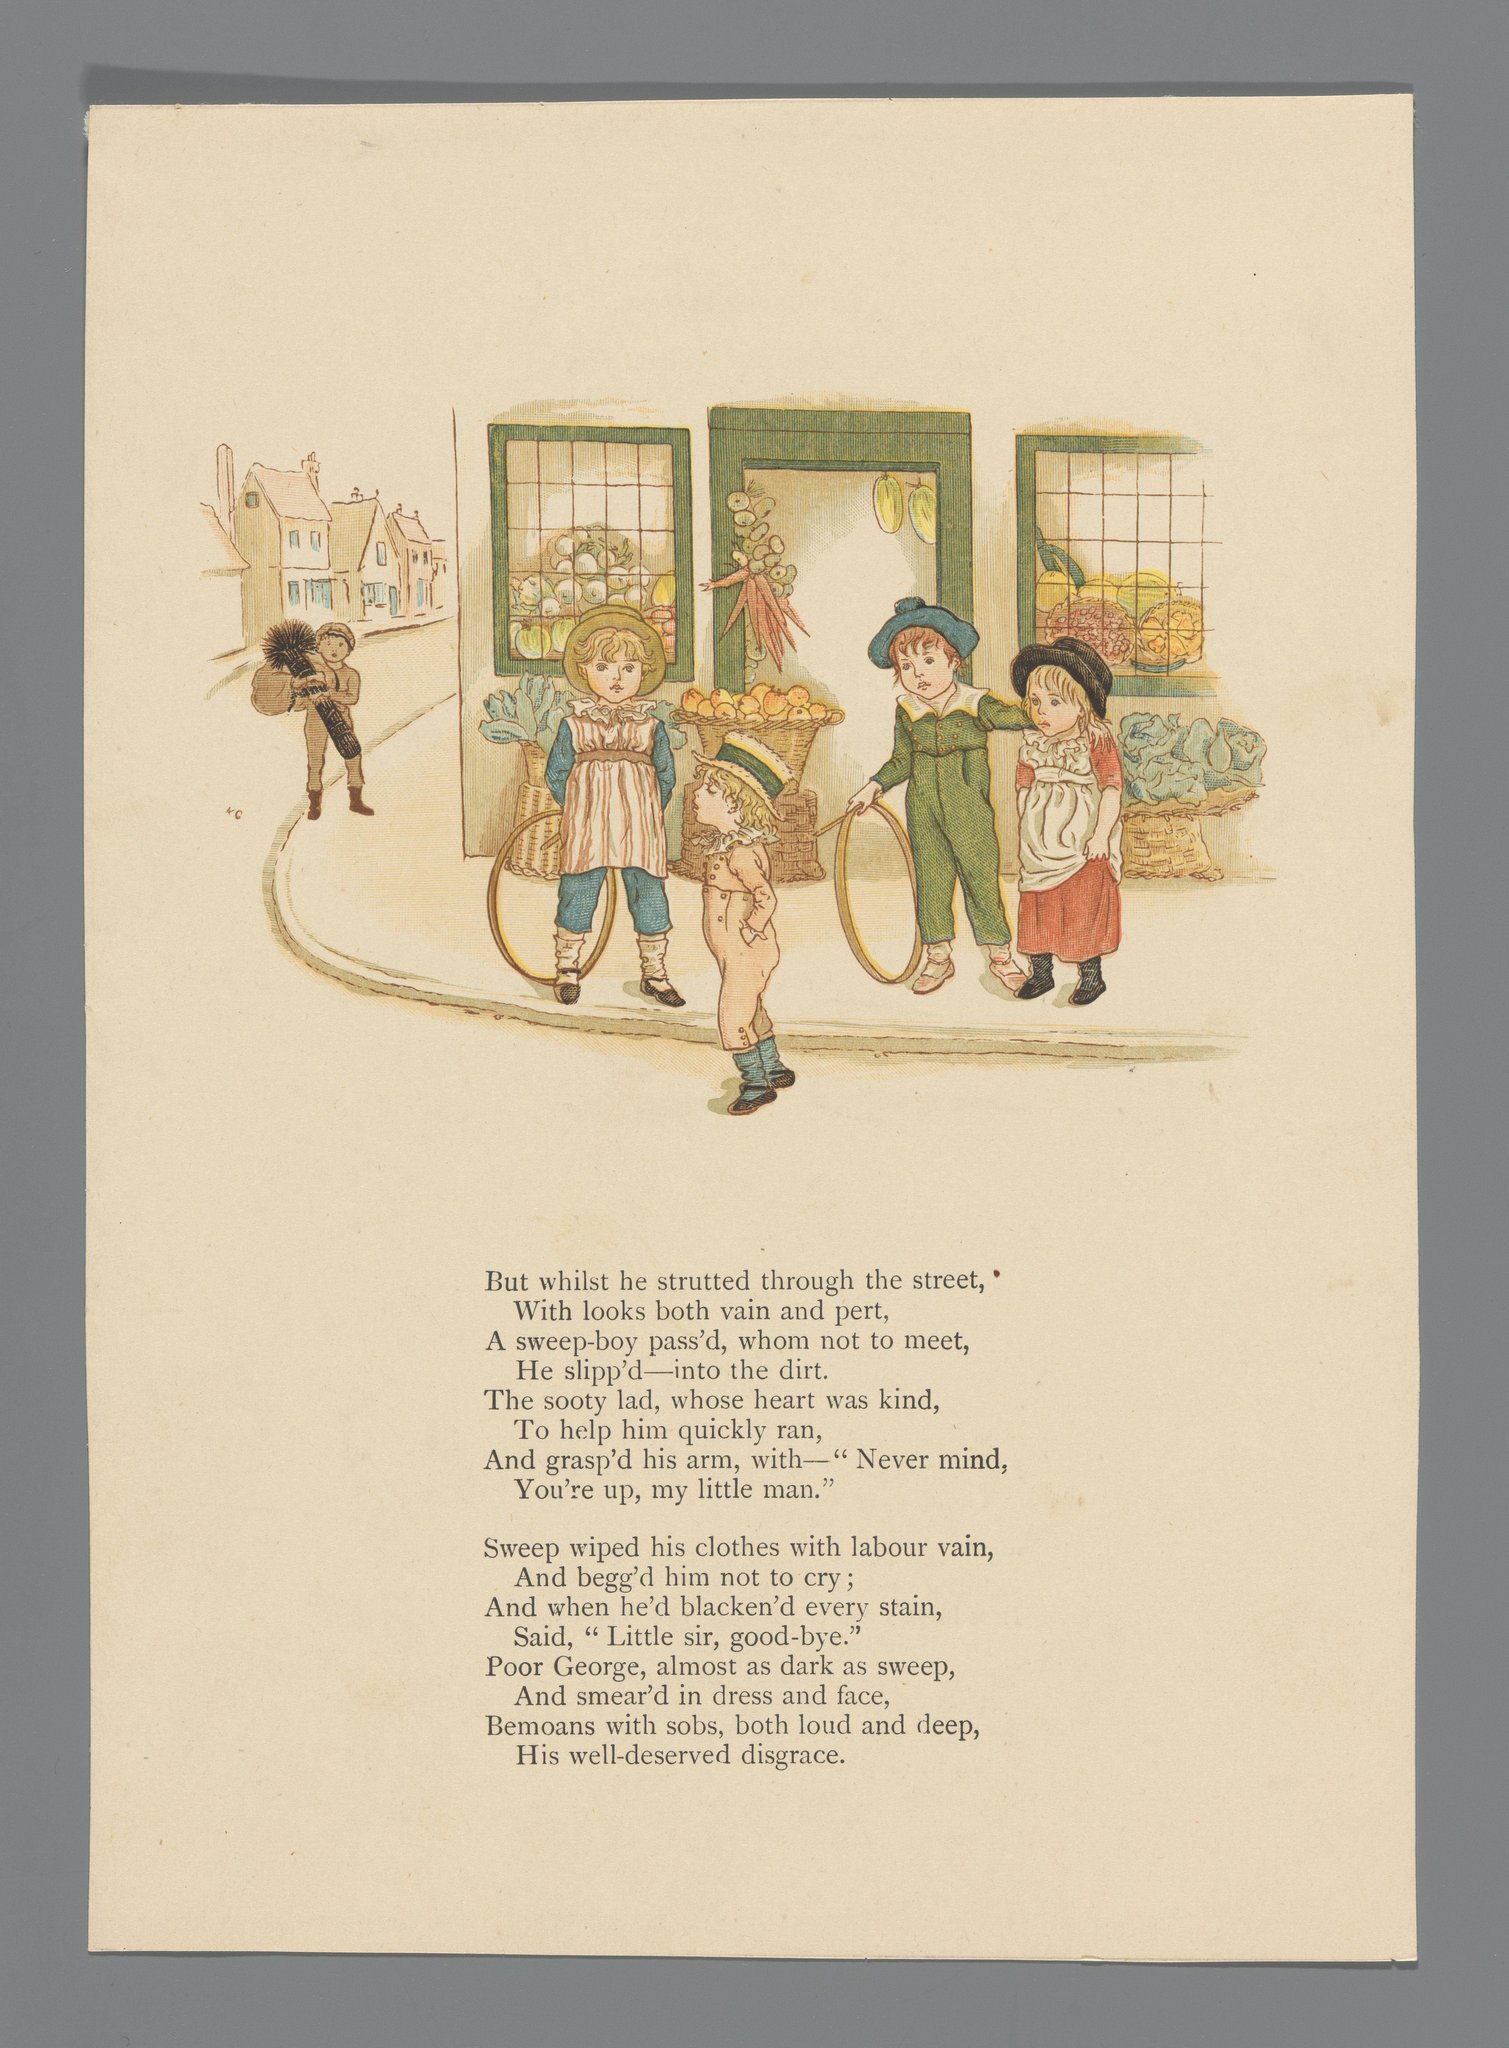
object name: book illustration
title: Vier spelende kinderen voor een winkel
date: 1883-1927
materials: paper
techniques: wood engraving, letterpress printing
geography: london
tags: shop, store, child (+ four persons), games using special objects (marbles, top, hoop, etc.)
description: Prent uit: Jane en Ann Taylor. Little Ann and other poems. Londen: George Routledge & Sons, [1883], p. 30. Of een latere uitgave.